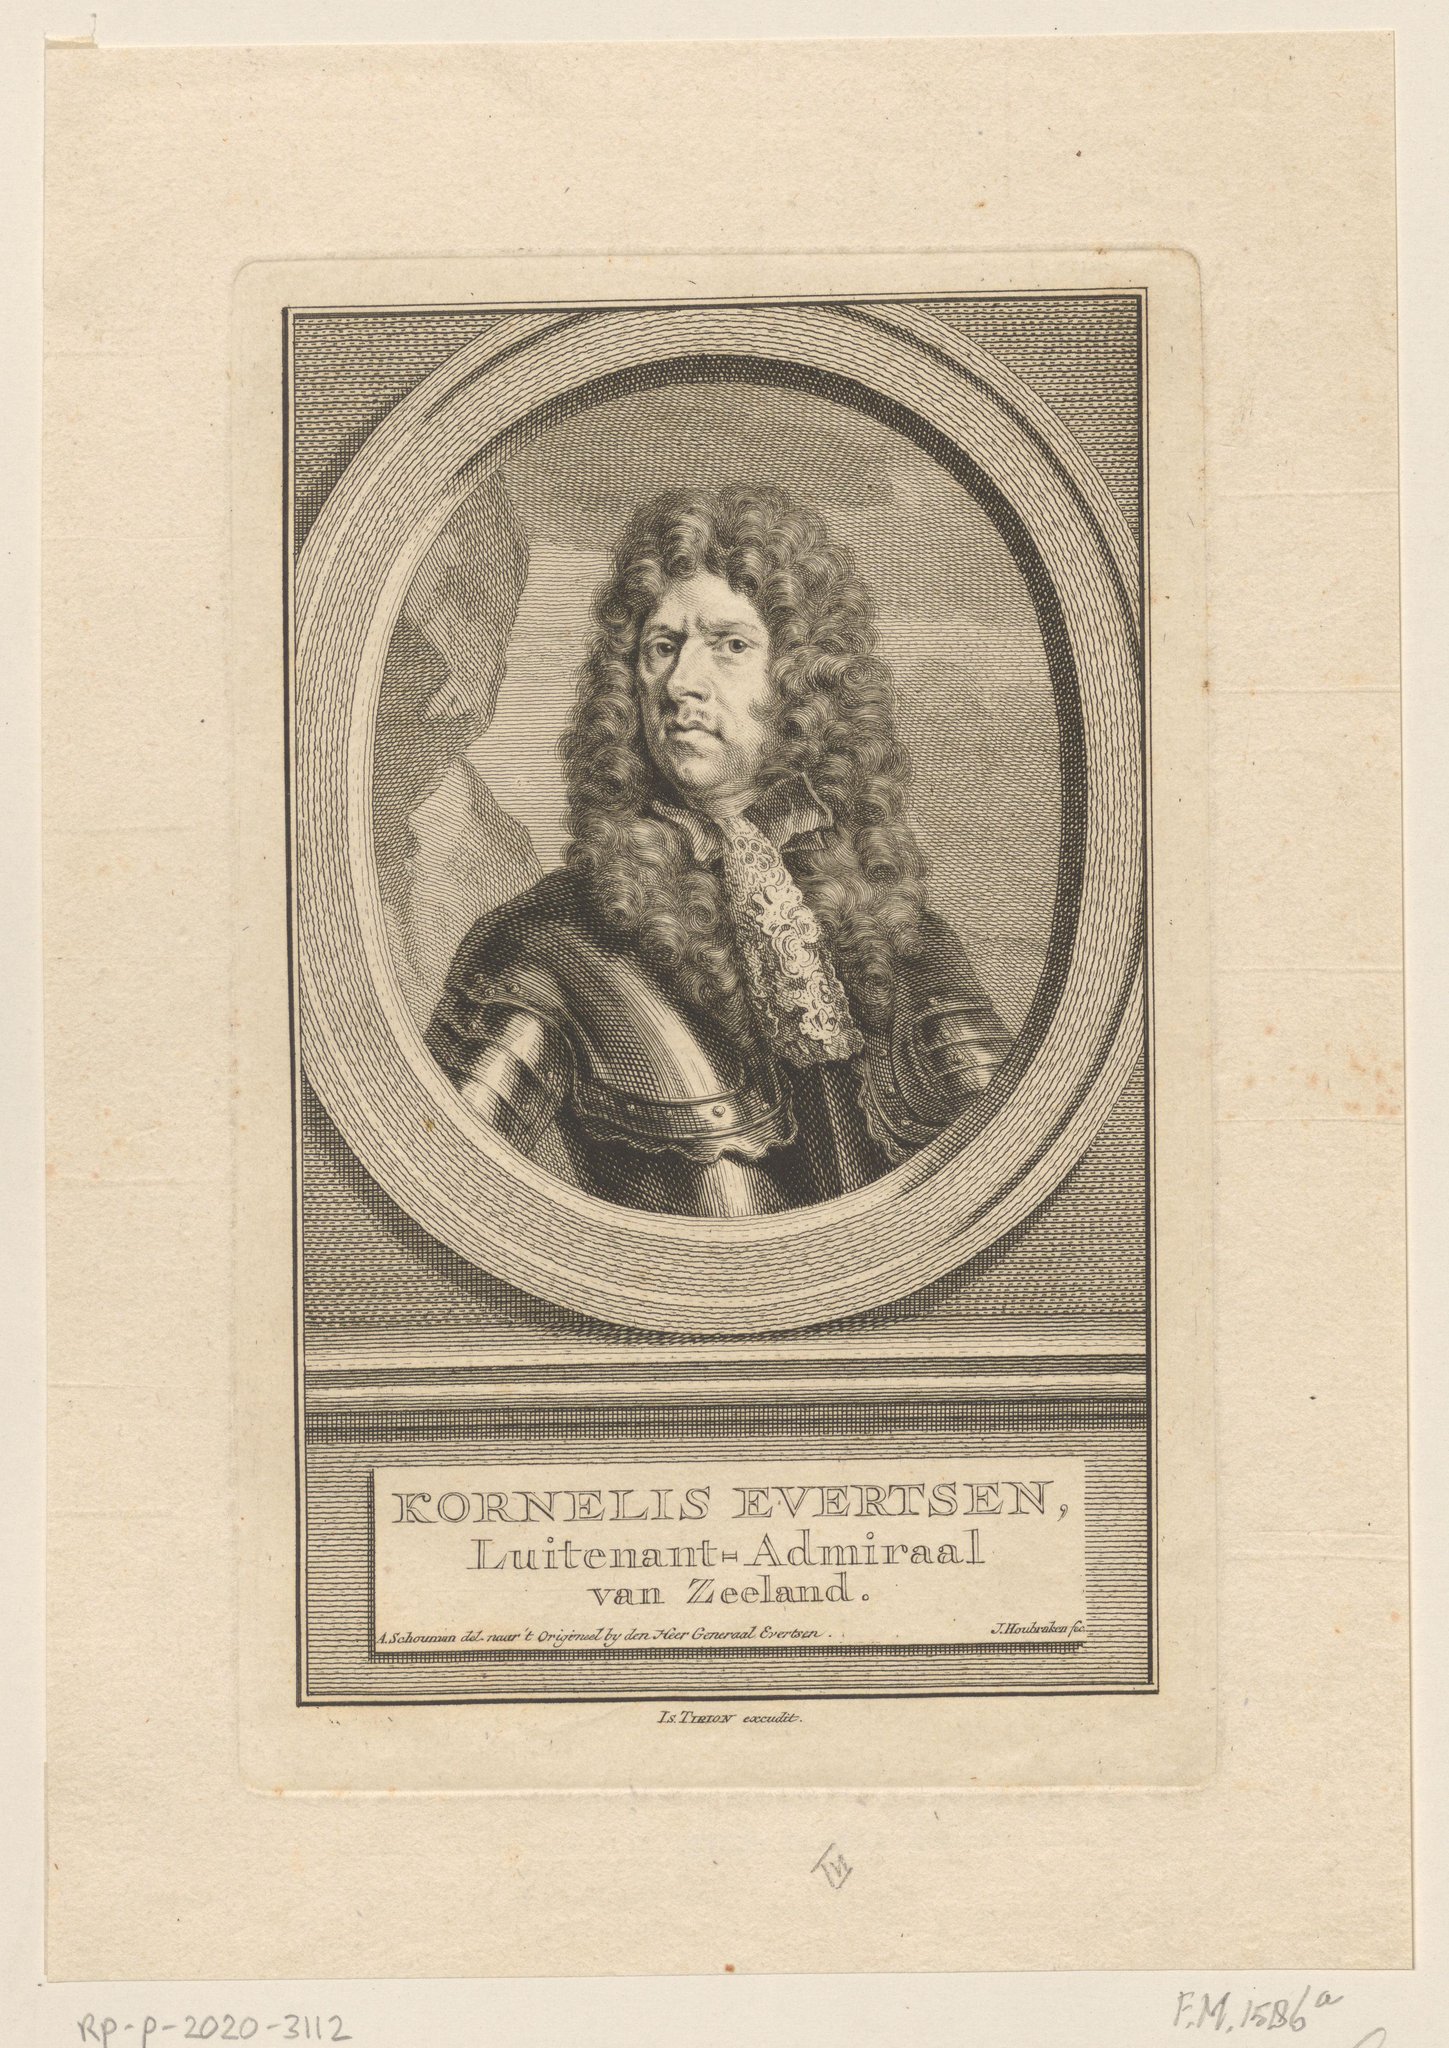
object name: print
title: Portret van Cornelis Evertsen (II)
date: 1756-1760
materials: paper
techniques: engraving, etching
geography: amsterdam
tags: cornelis evertsen (ii), historical persons, commander-in-chief, admiral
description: Prent waarschijnlijk uit: Wagenaar, Jan. Vaderlandsche historie, vervattende de geschiedenissen der nu Vereenigde Nederlanden, inzonderheid die van Holland (...), 21 dln. Amsterdam, Isaak Tirion, 1756, dl. 15. Prent volgens Ver Huell ook gebruikt in: Portraiten van eenige der vermaardste staatsmannen en zeehelden, als toevoeging op: Willem Tiberius Hattinga, Atlas van Zeeland. Amsterdam: Isaak Tirion, 1760. Latere staat gebruikt in de editie van 'Vaderlandsche historie (...)' uit 1770.